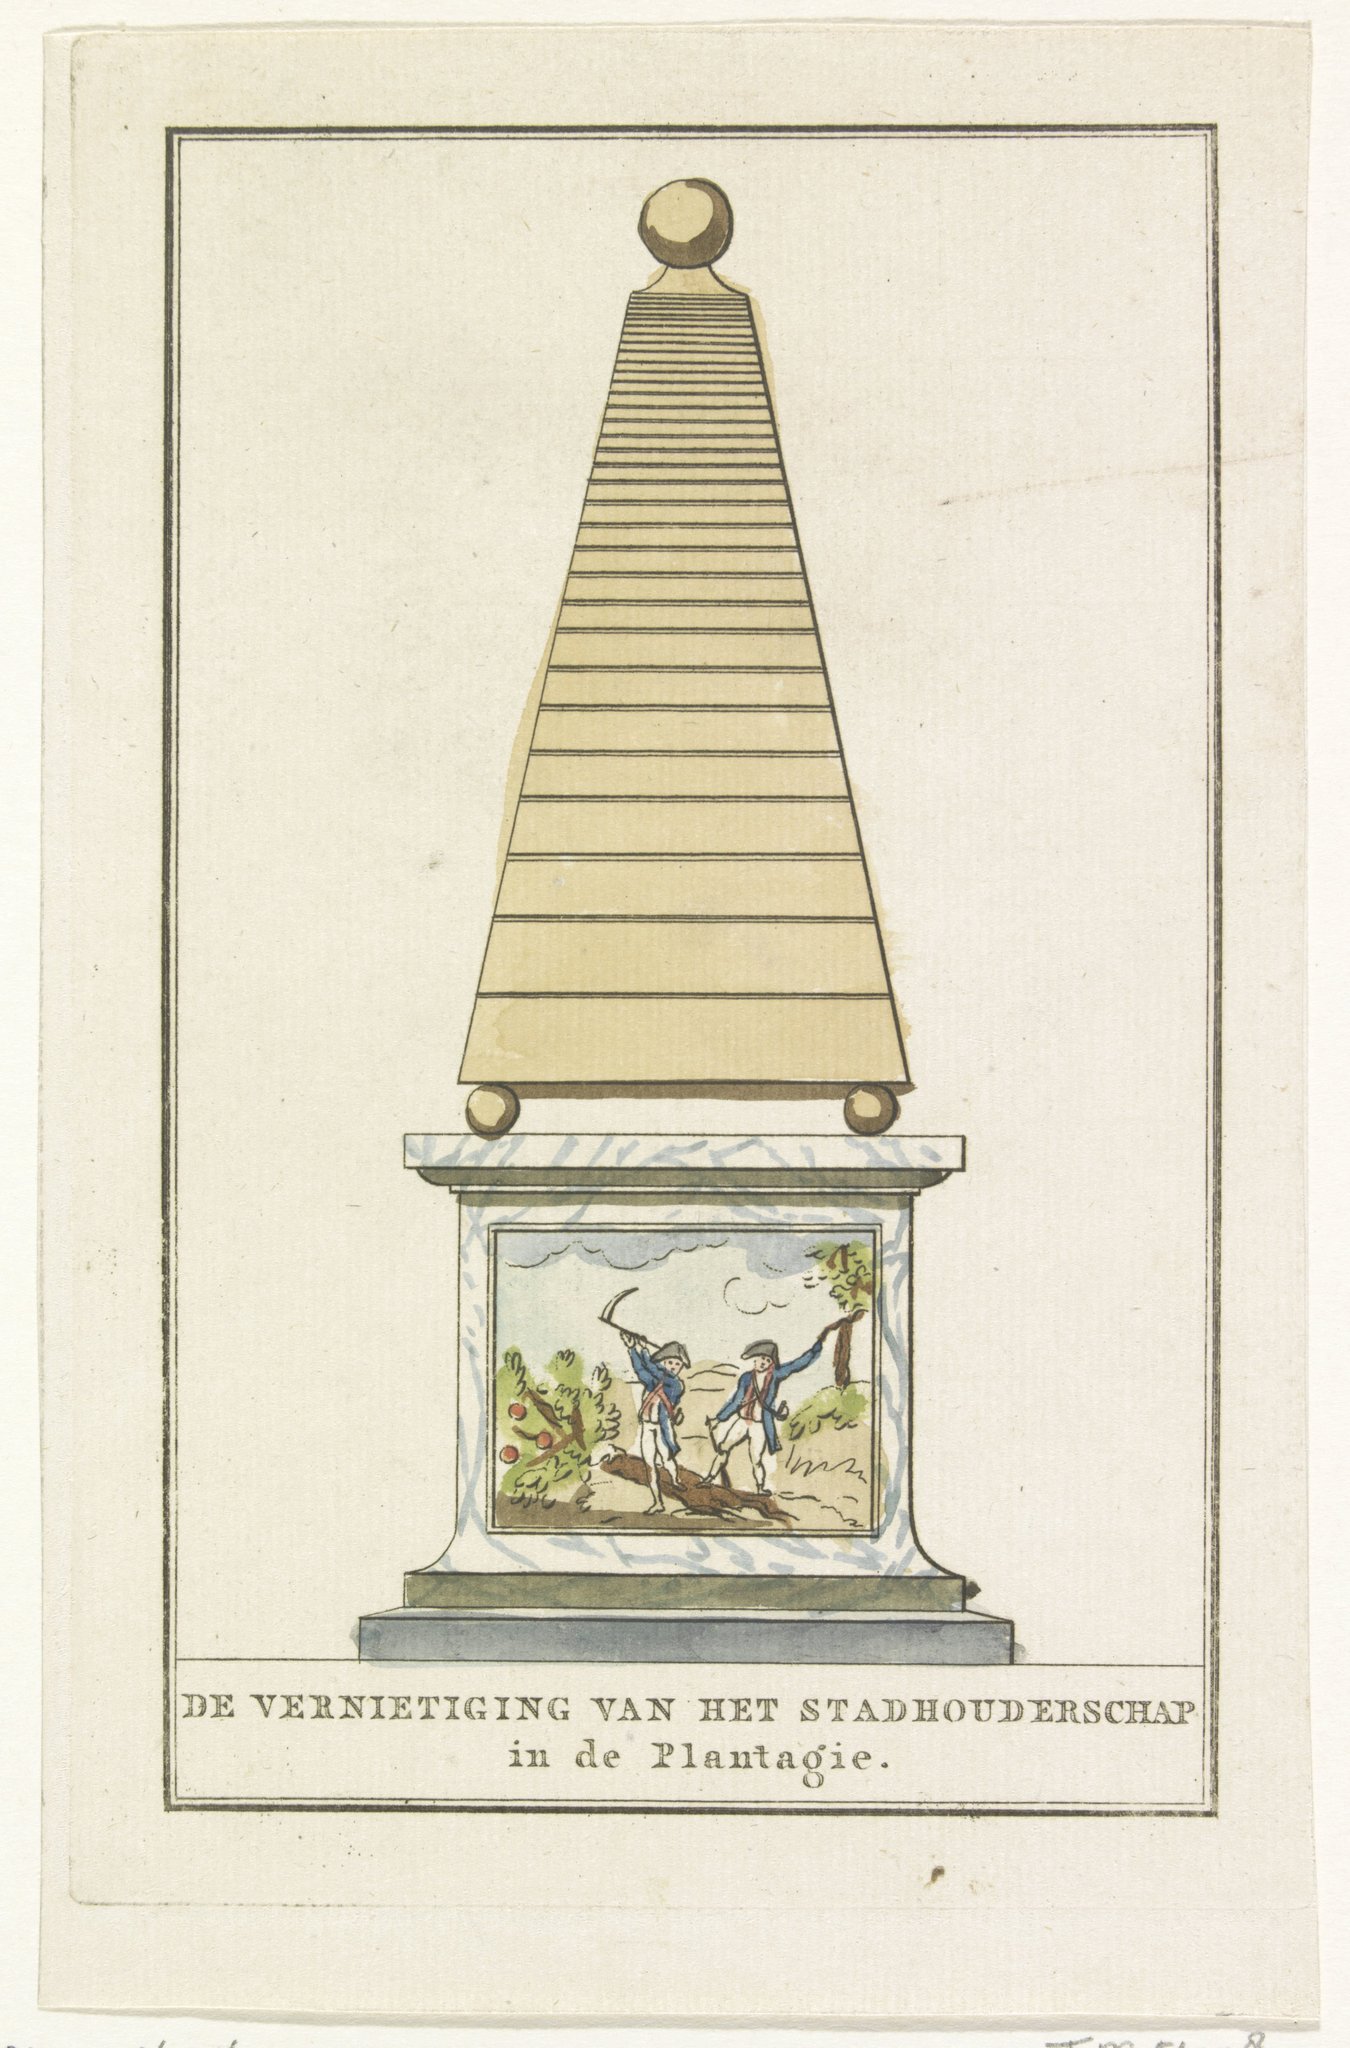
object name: print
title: Vernietiging van het stadhouderschap, decoratie in de Plantage, 1795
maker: noach van der meer (ii)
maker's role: draughtsman, print maker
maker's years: 1741-1822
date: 1795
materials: paper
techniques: etching, hand coloring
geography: netherlands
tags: festivities on events of national importance (+ festive decoration ~ festive activities), amsterdam, alliance with france (1795)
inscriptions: collector's mark: Lugt 2228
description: De Vernietiging van het stadhouderschap, allegorische decoratie opgericht in de Plantage te Amsterdam. Een Bataaf en een Fransman hakken de Oranjeboom om. Uit het boekje met afbeeldingen van de versieringen opgericht in de stad bij de viering van de installatie van de representanten en de alliantie gesloten tussen de Franse en de Bataafse Republiek, 19 juni 1795. Bij de prent behoort een los blad met uitleg.